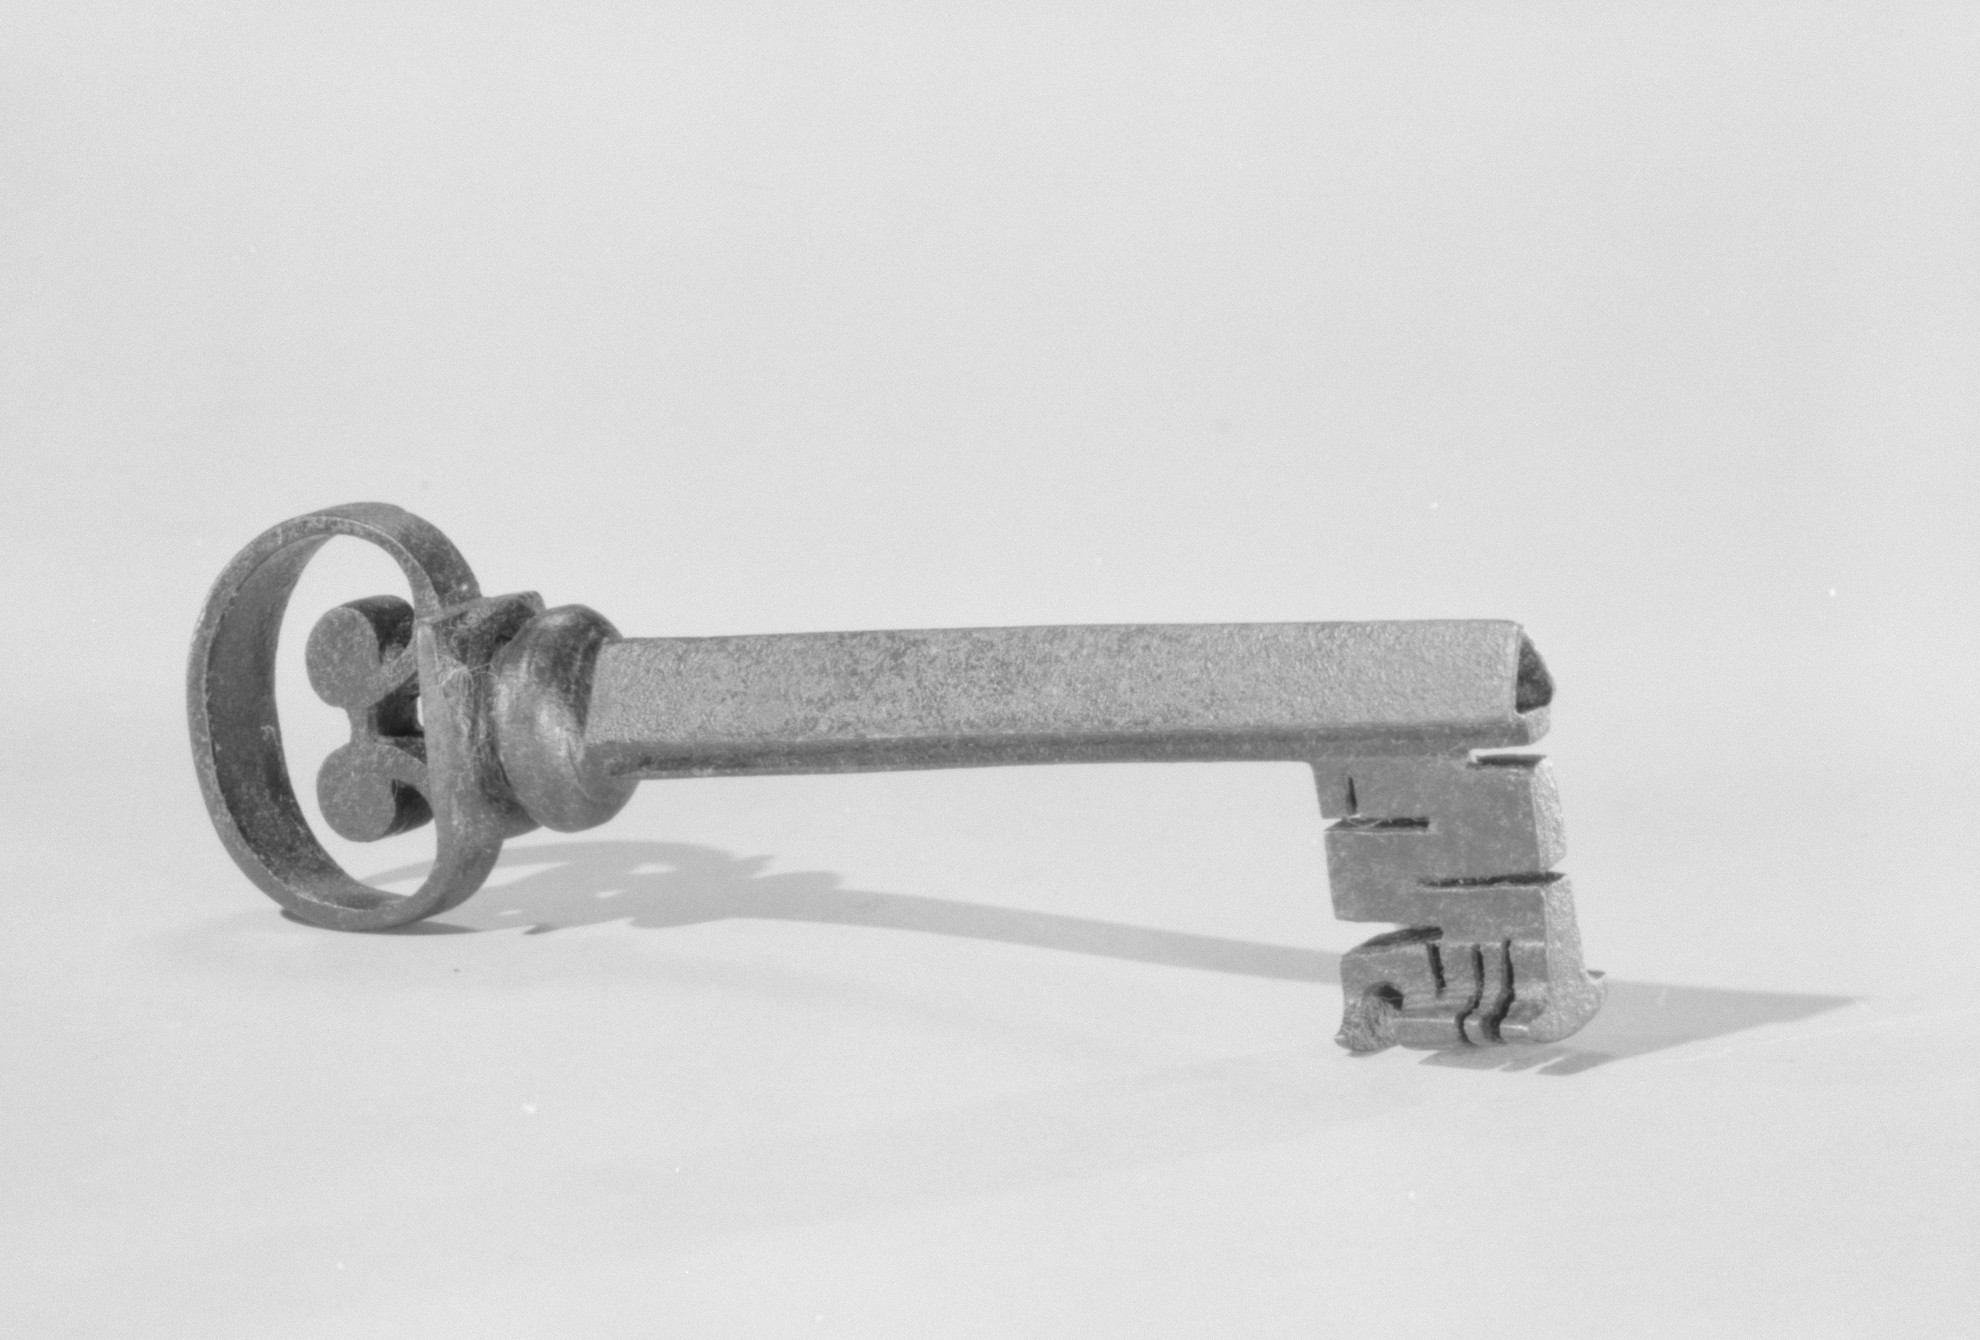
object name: coffer or chest key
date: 1601-1700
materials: iron